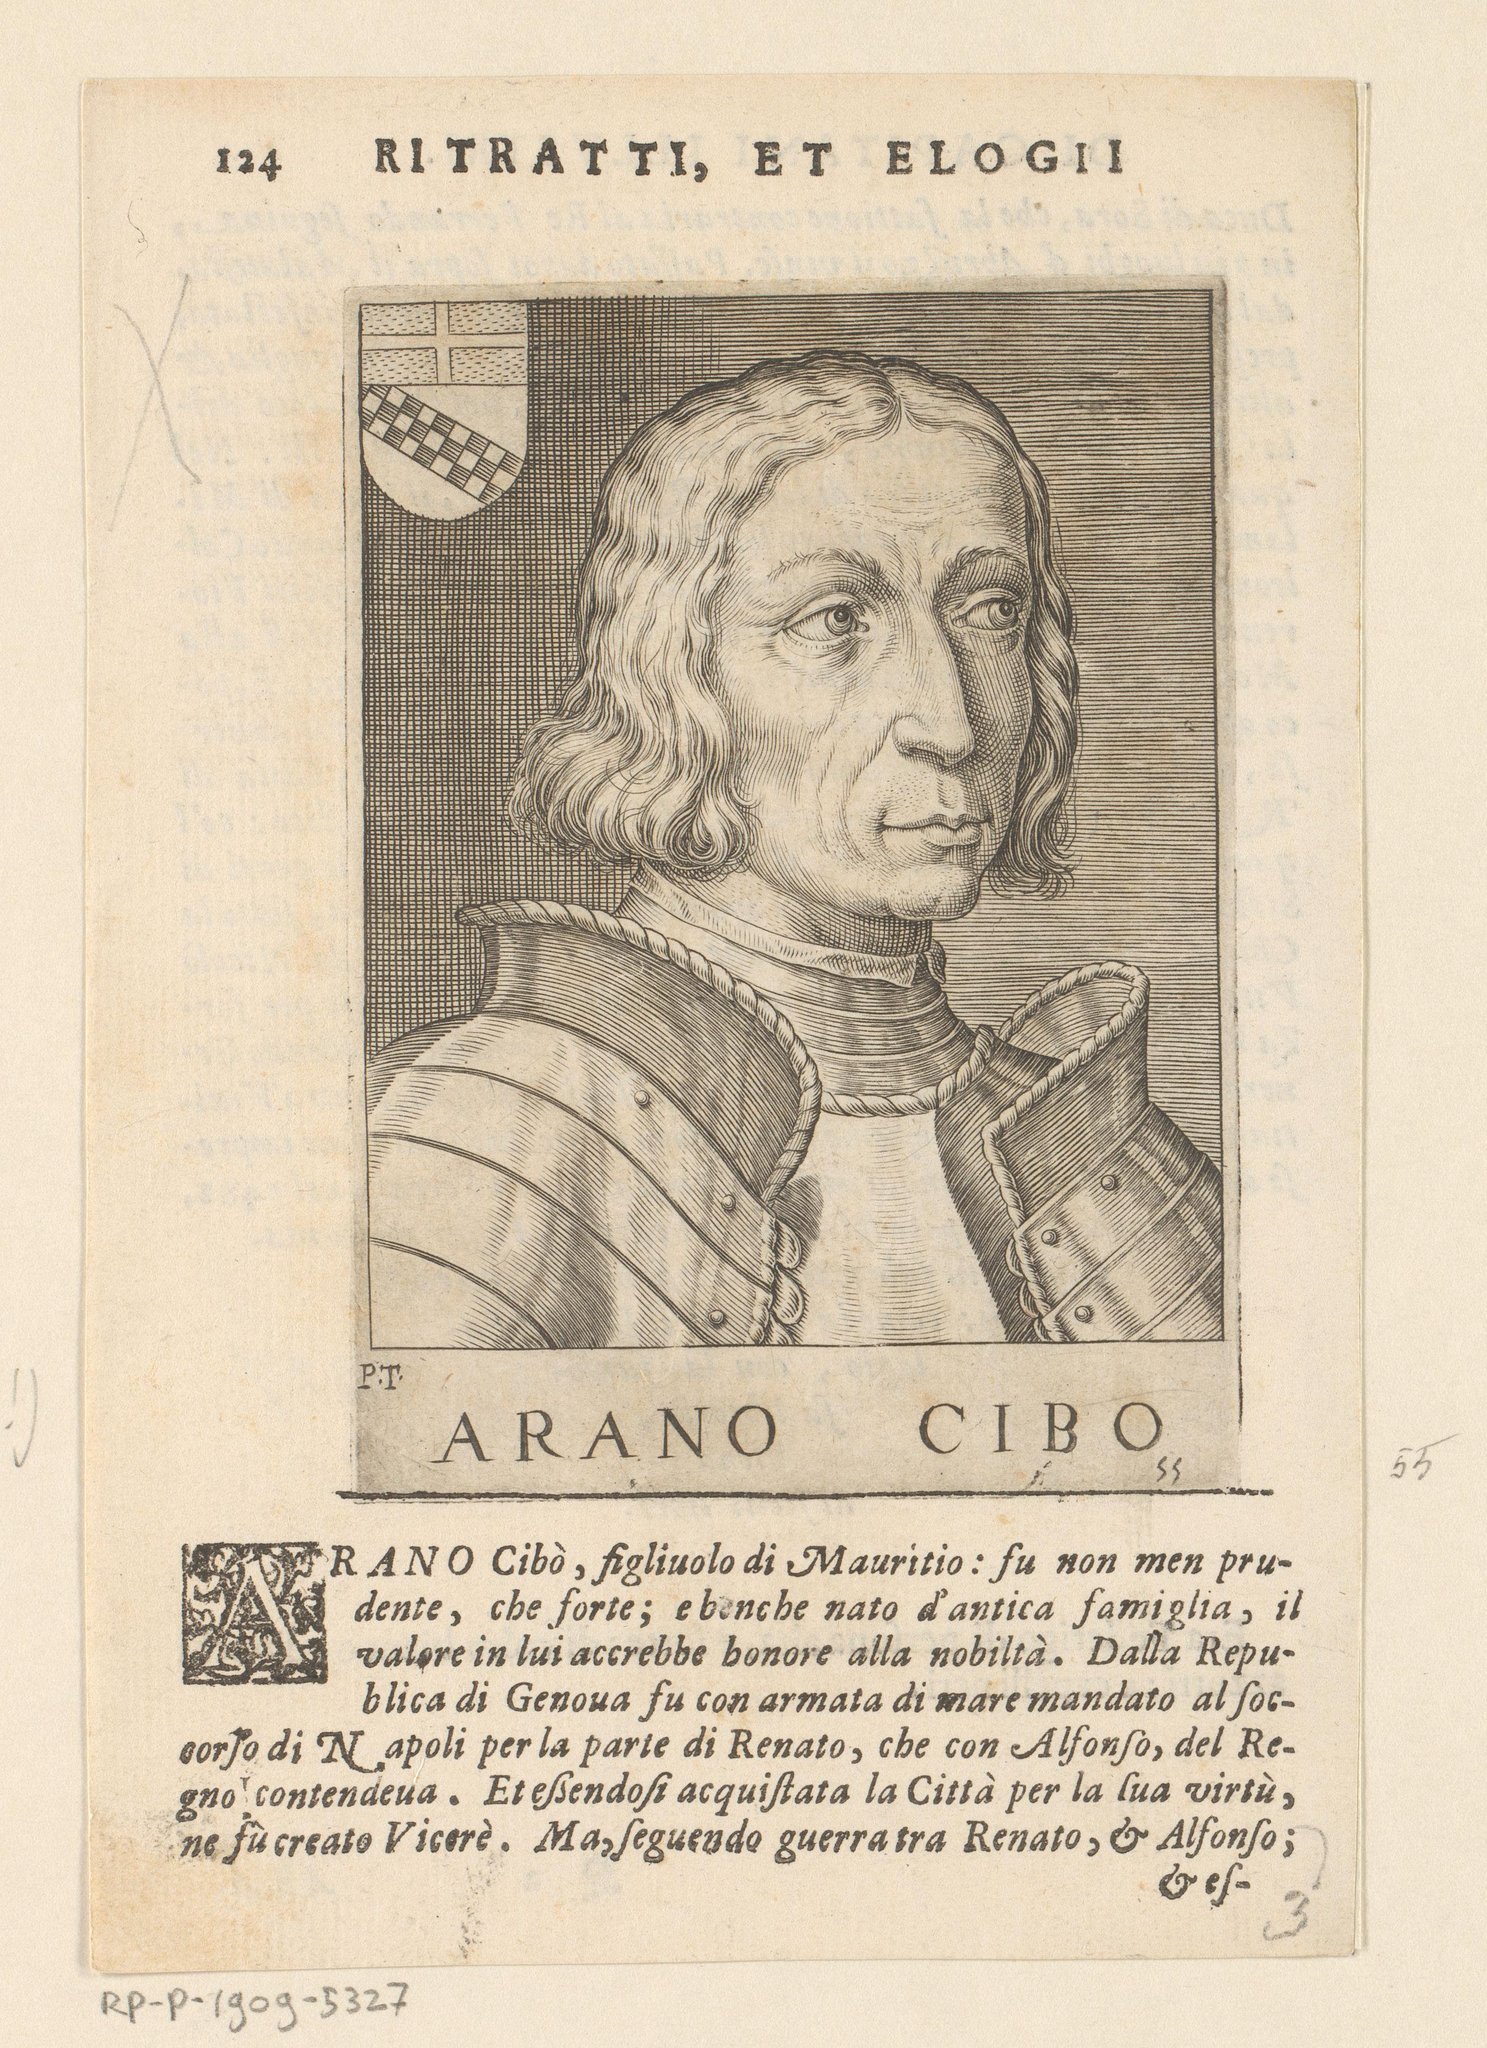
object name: book illustration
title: Portret van Arano Cibo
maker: pompilio totti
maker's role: print maker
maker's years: 1590-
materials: paper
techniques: engraving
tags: historical persons, armorial bearing, heraldry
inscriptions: collector's mark: Lugt 2228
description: Tweede staat van prent ook gebruikt in: Ritratti et elogii di capitani Illustri. Rome: Pompilio Totti en Andrea Fei, 1635, p.124. Derde staat van prent in ieder geval ook gebruikt in: Ritratti et elogii di capitani Illustri. Che ne'secoli moderni hanno gloriosamente guerreggiato. Rome: Filippo de'Rossi en Vitale Mascardi, 1646.